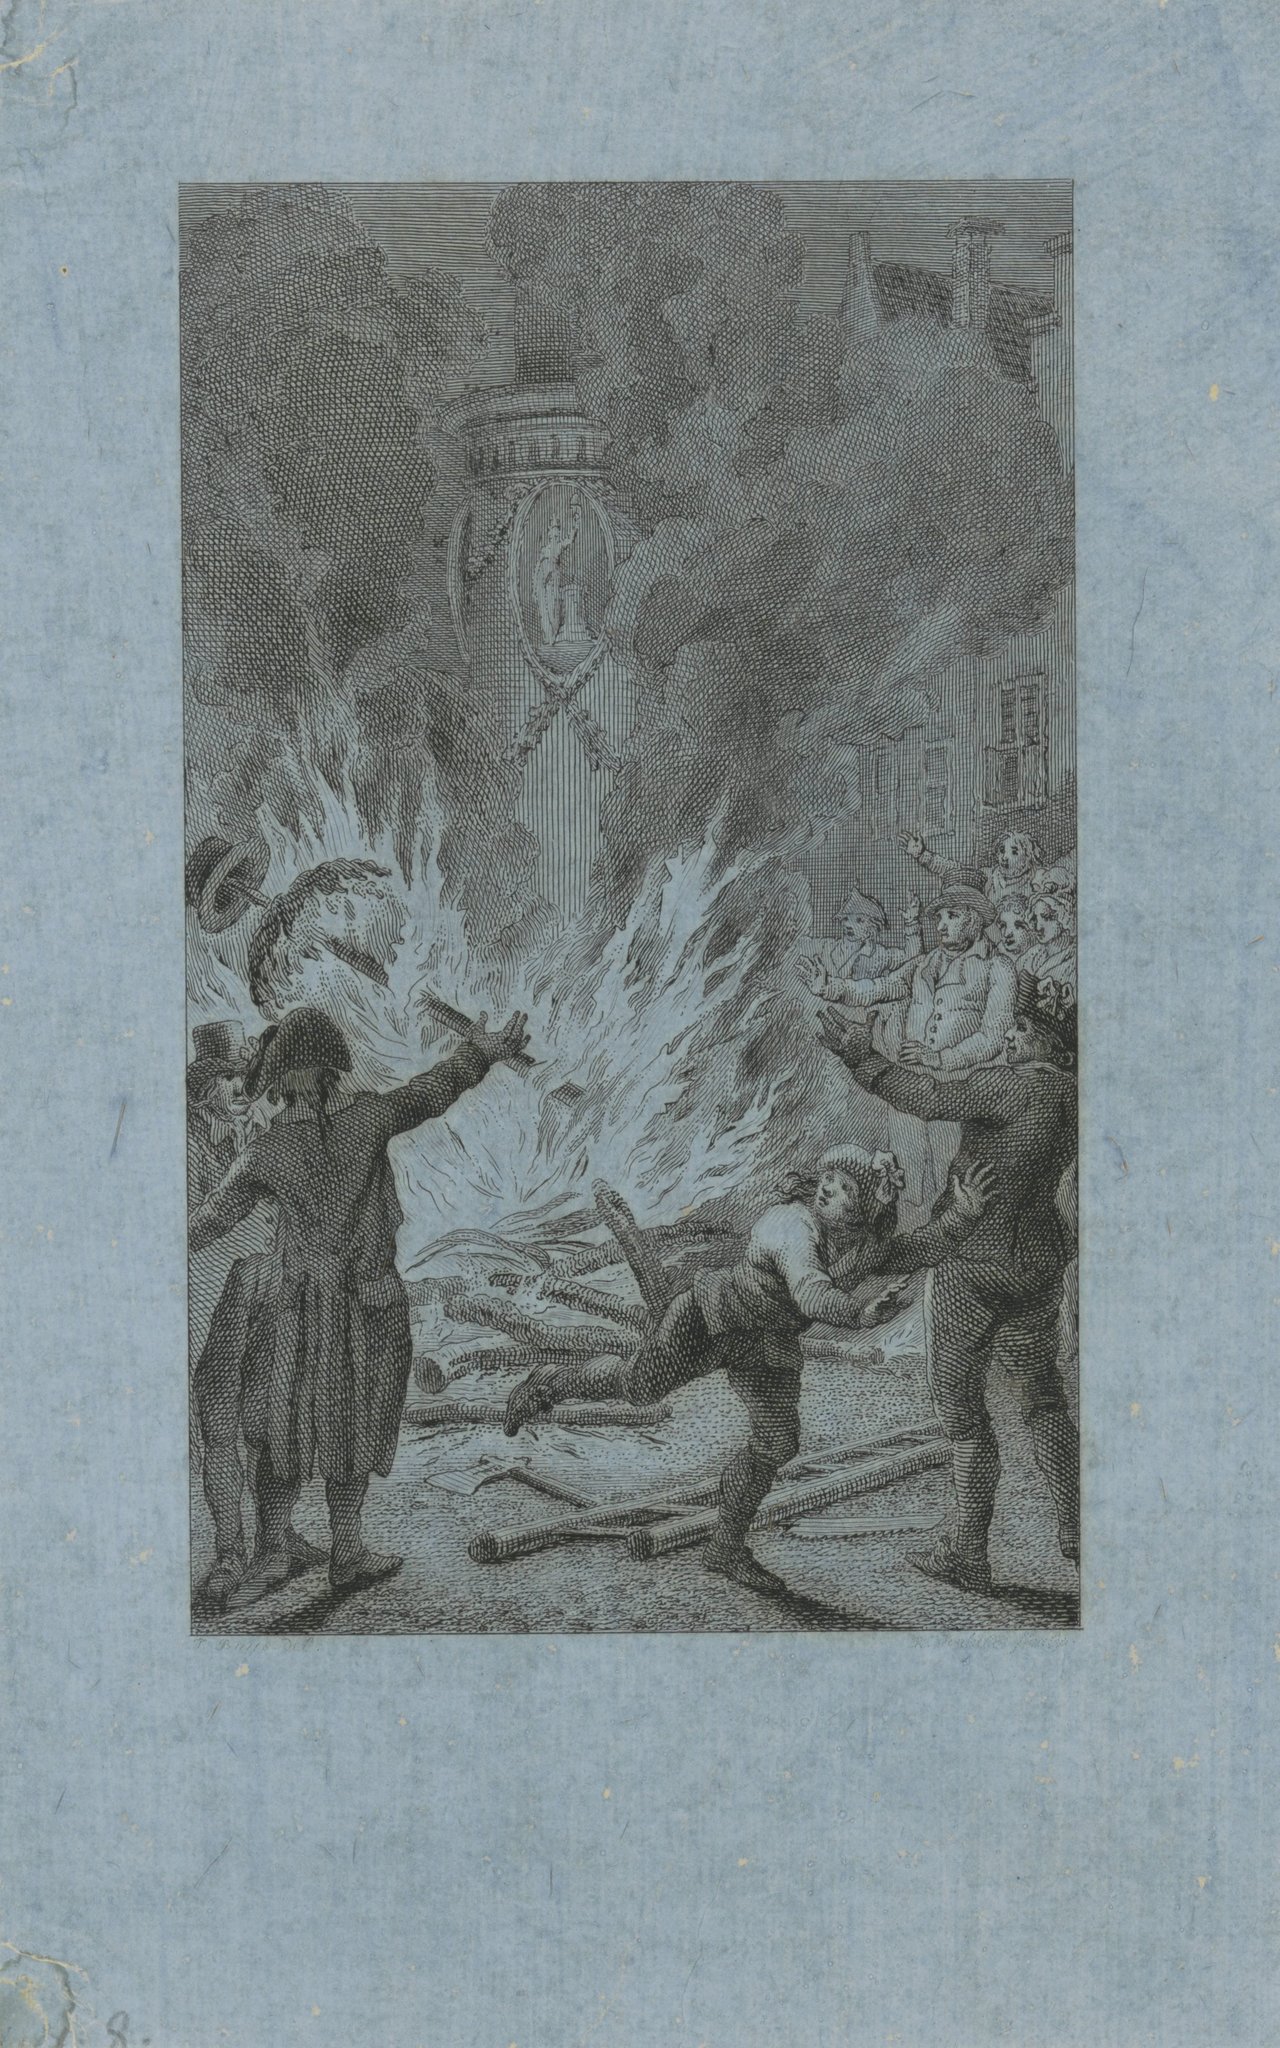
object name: history print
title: Verbranden van de Vrijheidsboom te Breda 1793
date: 1801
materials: paper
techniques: engraving, etching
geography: northern netherlands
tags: on fire, ablaze, dancing around the tree of liberty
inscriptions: collector's mark: Lugt 2228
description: Gebruikt als illustratie in: P.A. Loosjes. Vaderlandsche historie, vervattende de geschiedenissen, der Vereenigde Nederlanden (...). Ten onmiddelyken vervolge van Wagenaar's Vaderlandsche historie. Amsterdam: Johannes Allart, dl. 26 (1801).